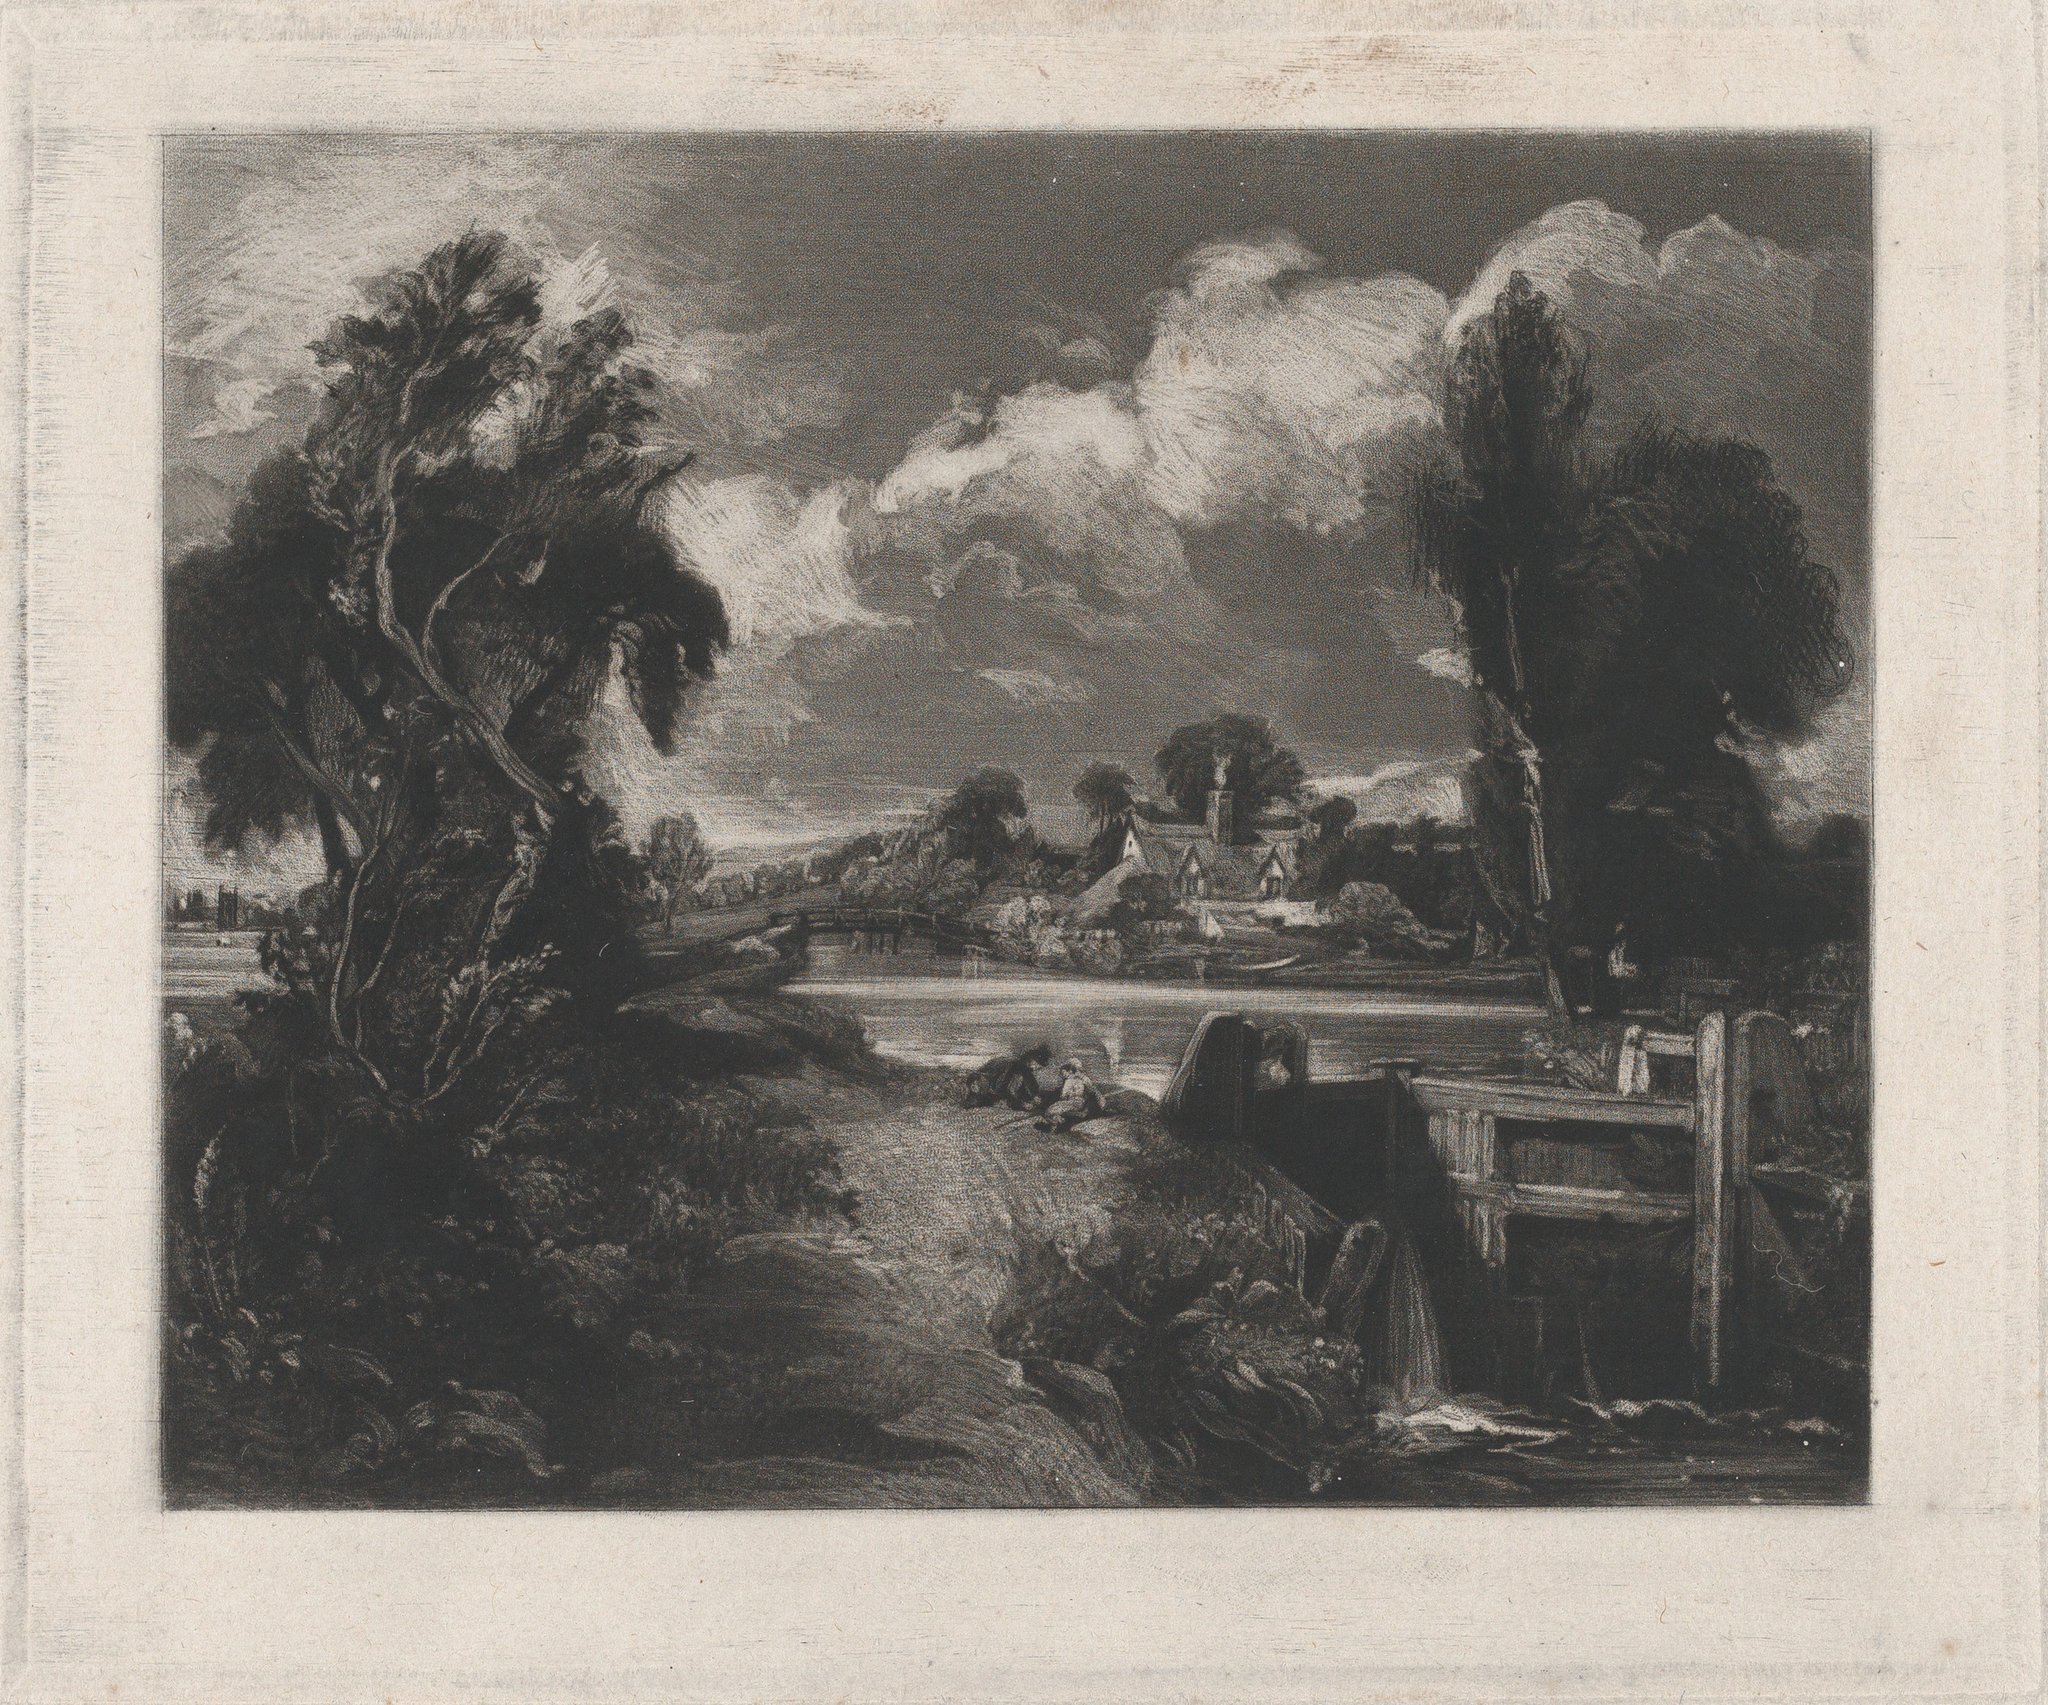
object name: print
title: A Lock on the Stour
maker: david lucas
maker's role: artist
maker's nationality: british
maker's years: 1802-1881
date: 1830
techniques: mezzotint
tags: human figures,rivers,landscapes,trees